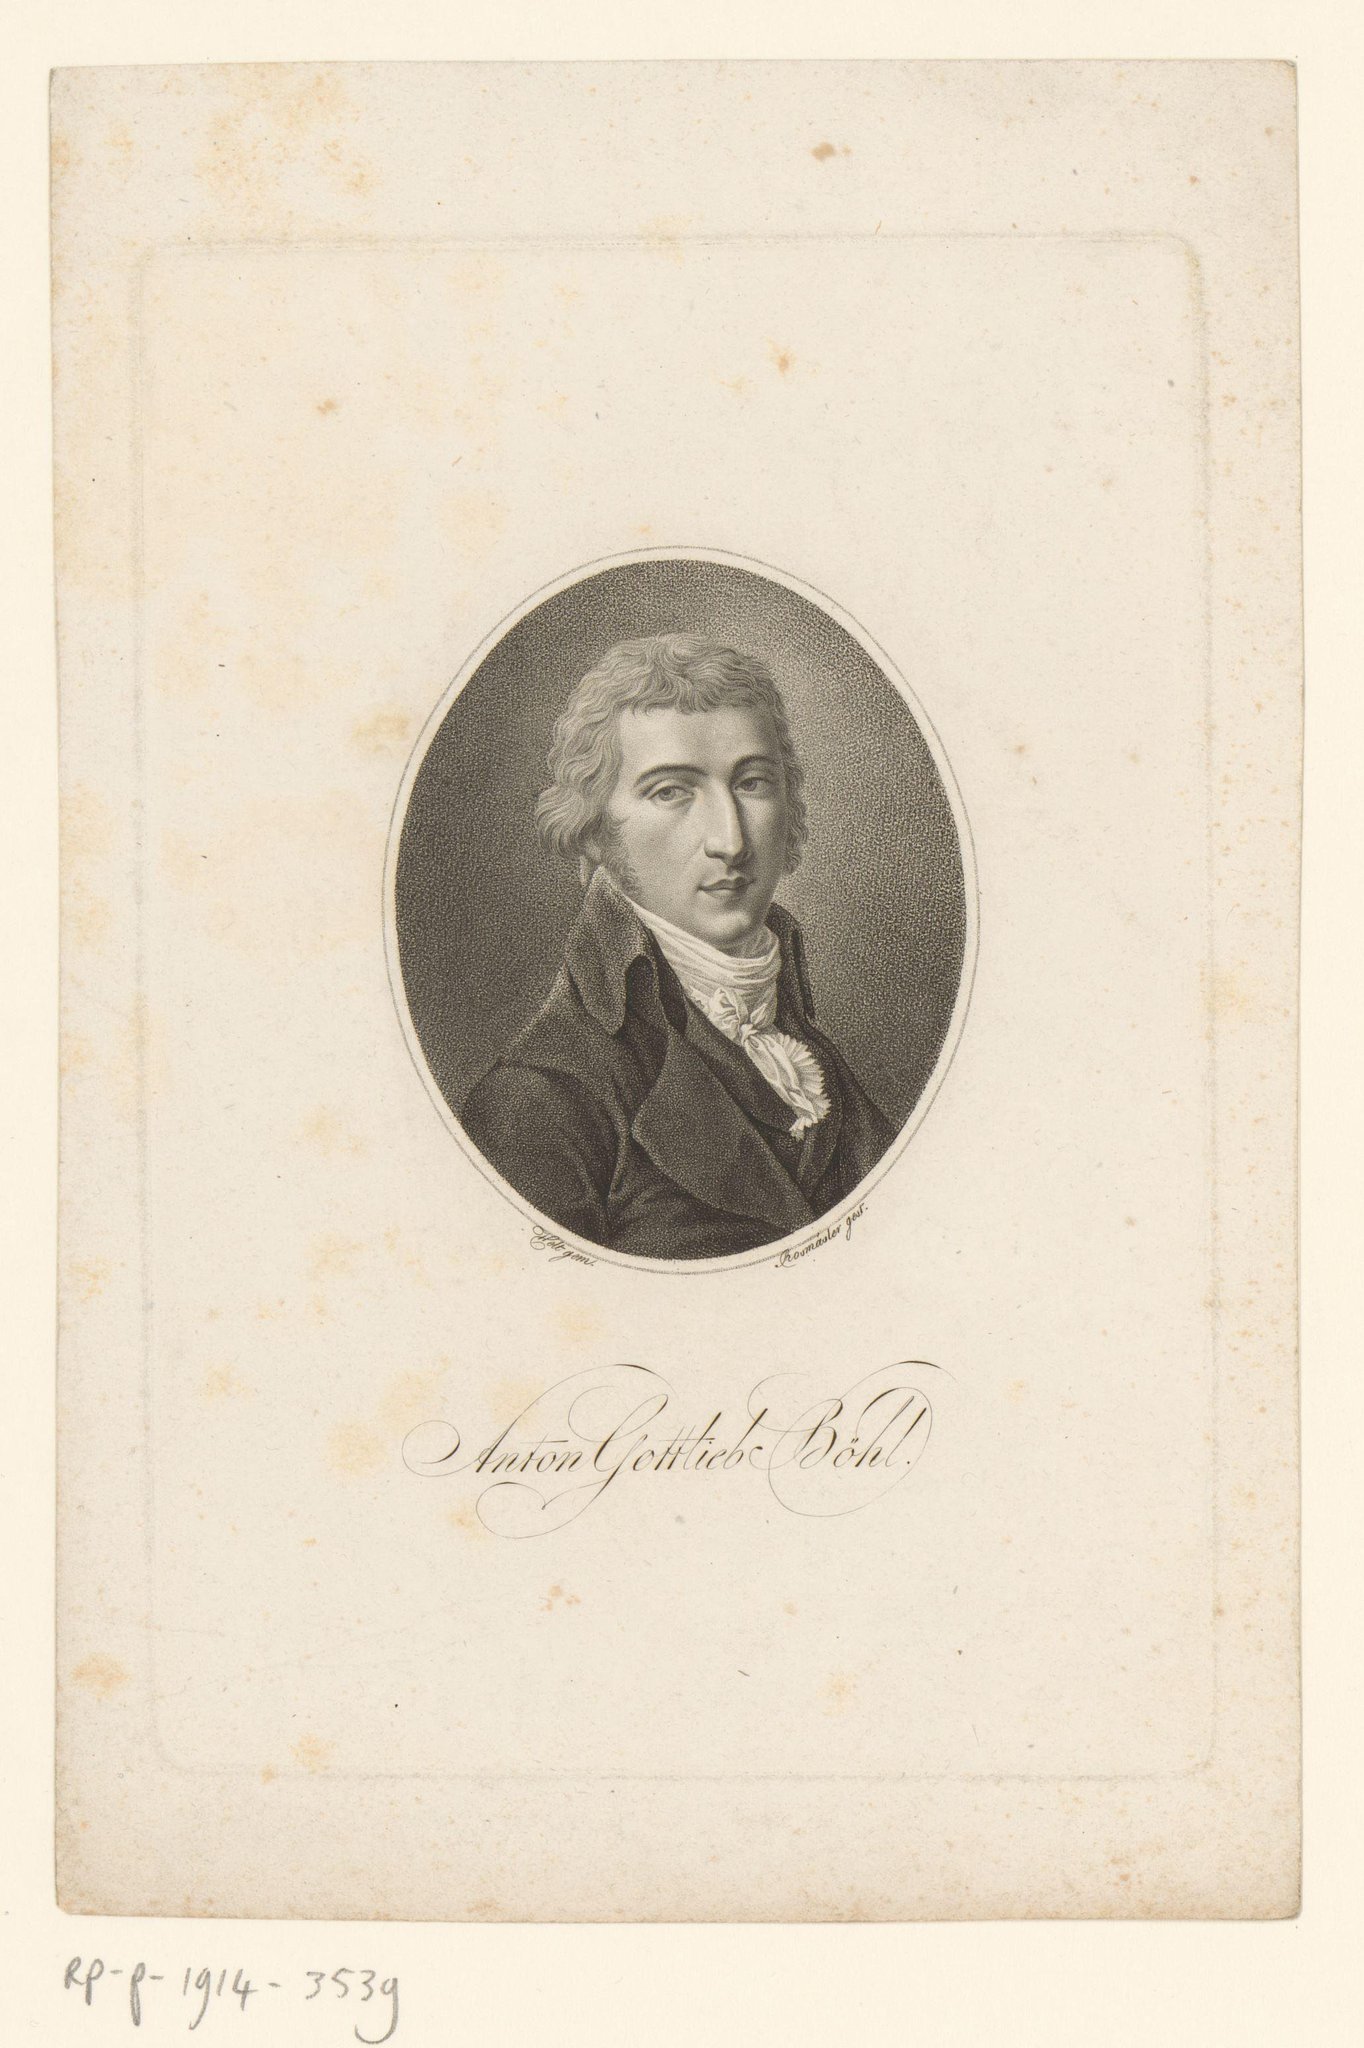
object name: print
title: Portret van Anton Gottlieb Böhl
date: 1797-1821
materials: paper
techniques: engraving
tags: historical persons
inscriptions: collector's mark: Lugt 2228